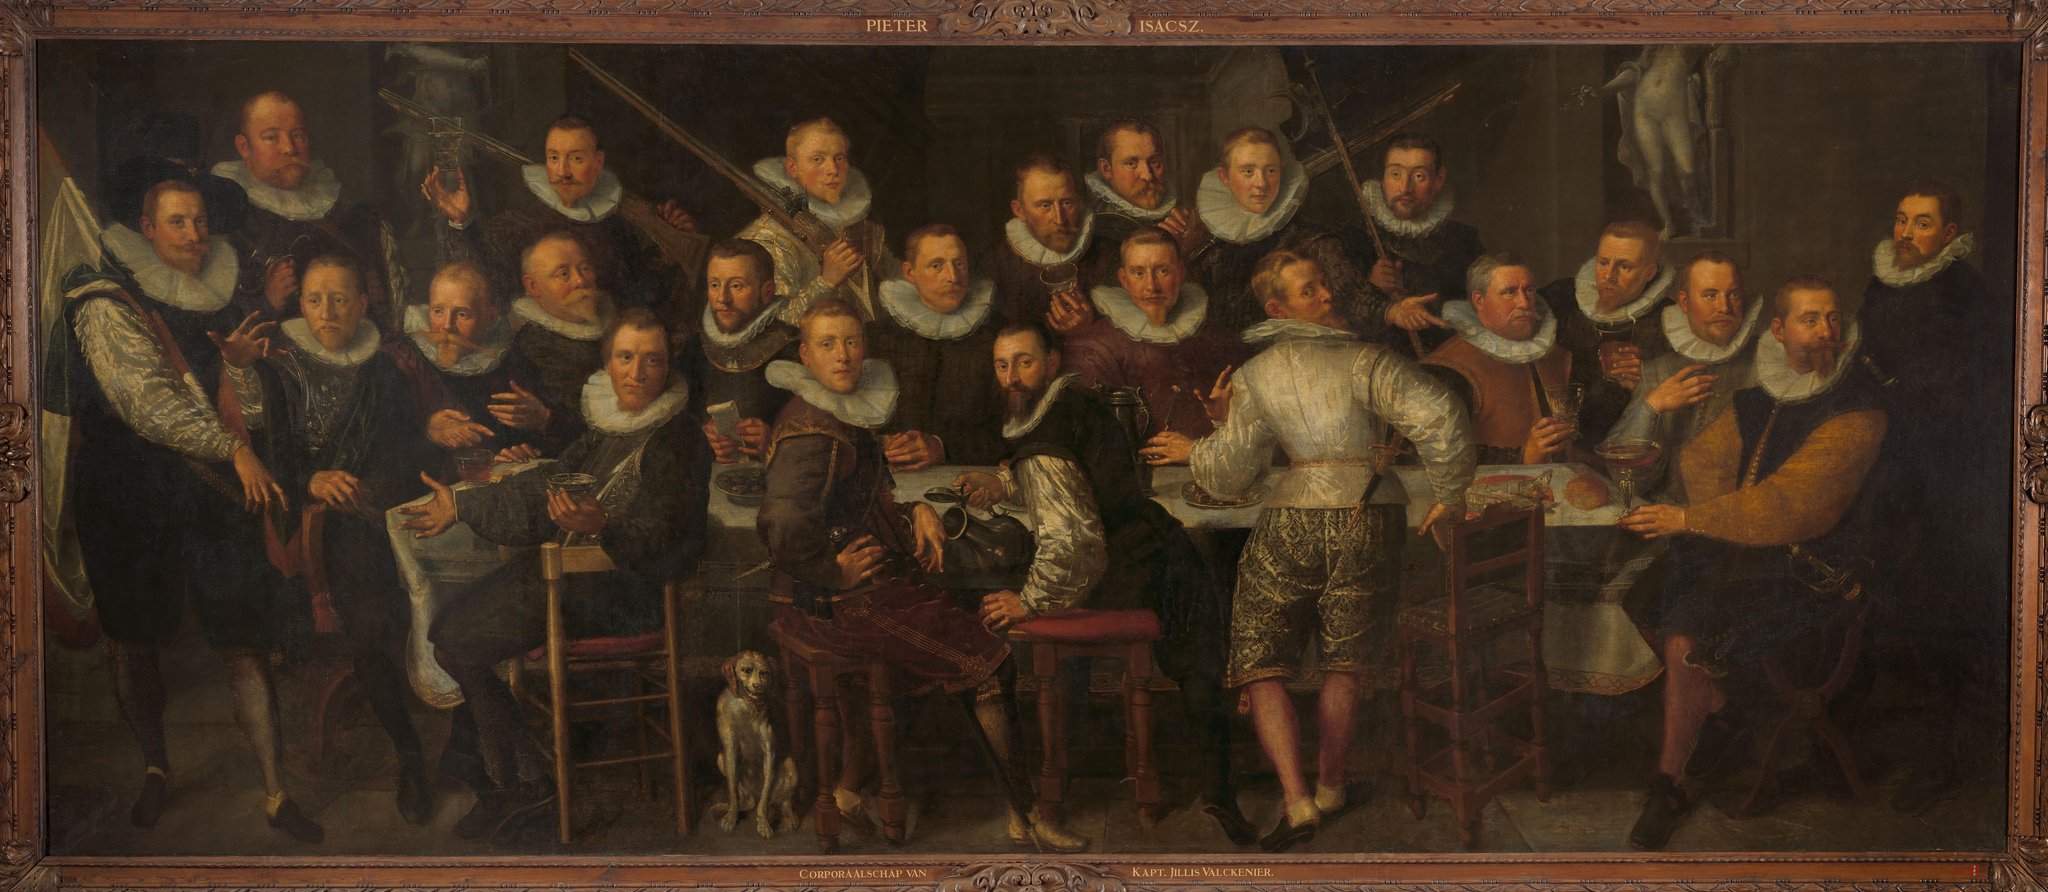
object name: painting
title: The Company of Captain Gillis Jansz Valckenier and Lieutenant Pieter Jacobsz Bas, Amsterdam, 1599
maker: pieter isaacsz.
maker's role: draughtsman, painter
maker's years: 1569-1625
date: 1599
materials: canvas, oil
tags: warfare; military affairs (+ citizen soldiery, civil guard, citizen militia)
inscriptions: date: ‘1599’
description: Het korporaalschap van kapitein Gillis Jansz Valckenier en luitenant Pieter Jacobsz Bas, Amsterdam, 1599. De schutters van de Voetboogdoelen zijn geportretteerd zittend of staand tijdens een maaltijd aan een tafel. Links de vaandrig, sommige mannen zijn gewapend met geweren, velen met een glas in de hand.